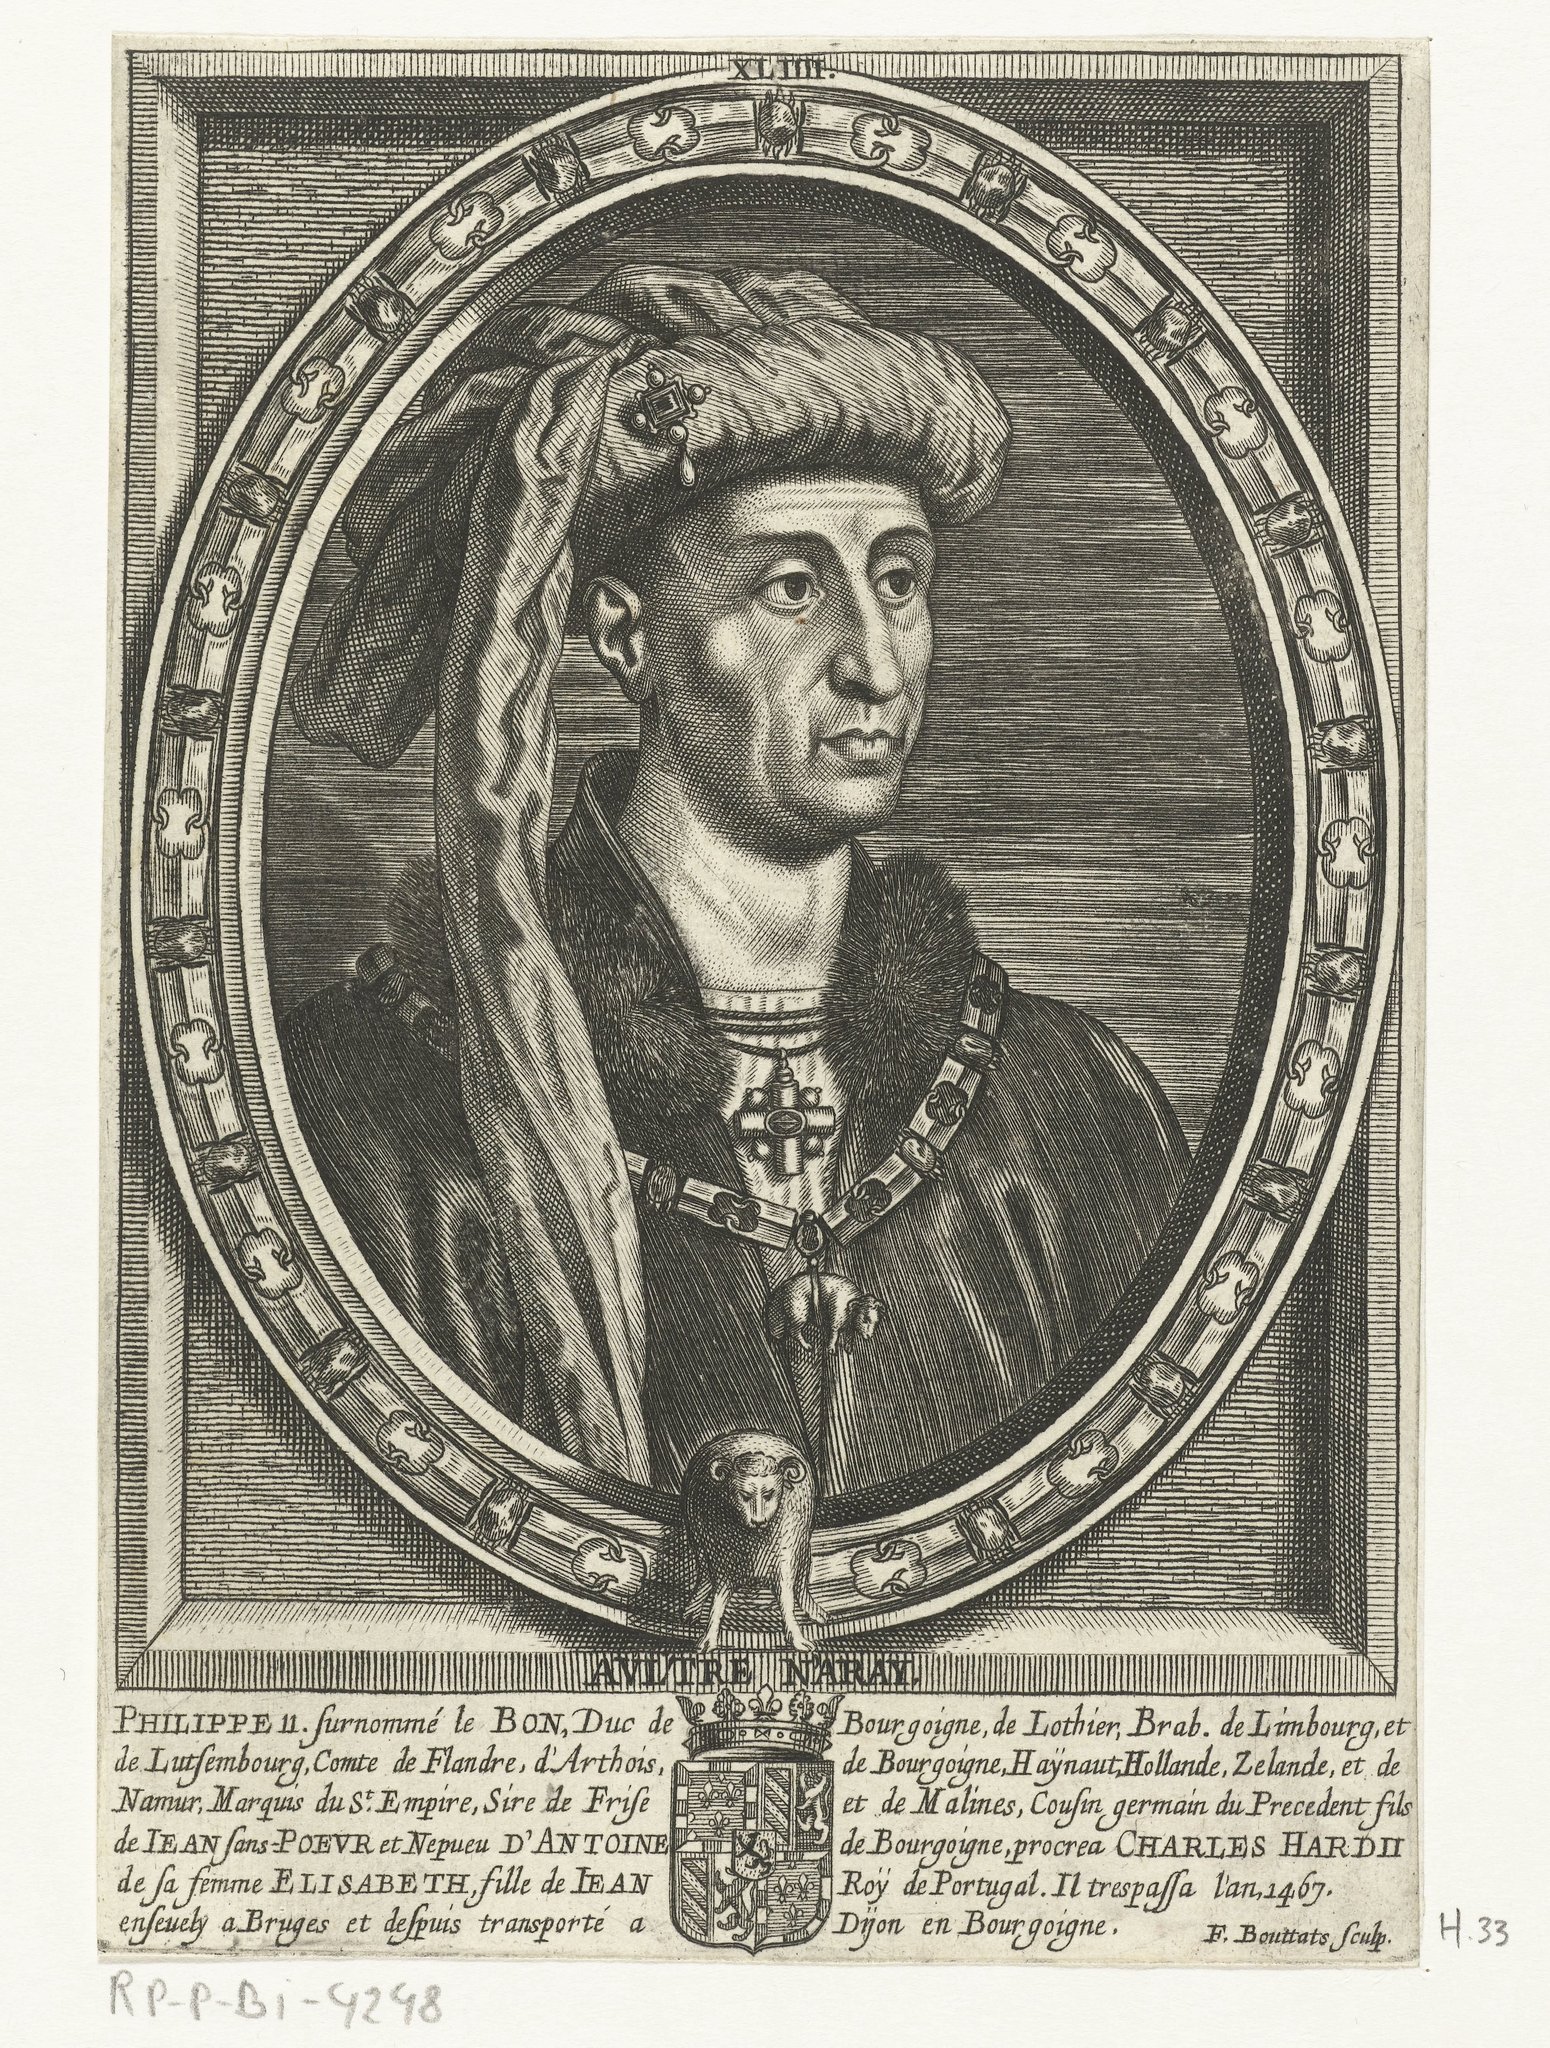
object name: print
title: Portret van Filips de Goede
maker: frederik bouttats (i)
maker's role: artist, painter, print maker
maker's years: 1590-1661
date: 1600-1676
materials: paper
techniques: engraving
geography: antwerp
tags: bruges, philip iii the good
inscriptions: collector's mark: Lugt 1838, collector's mark: Lugt 240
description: Portret in een ovale lijst van Filips de Goede, hertog van Bourgondië. Buste naar rechts. Filips de Goede draagt de keten van de Orde van Het Gulden Vlies. De prent heeft een Frans onderschrift met de naam van de geportretteerde en wat informatie over zijn leven.